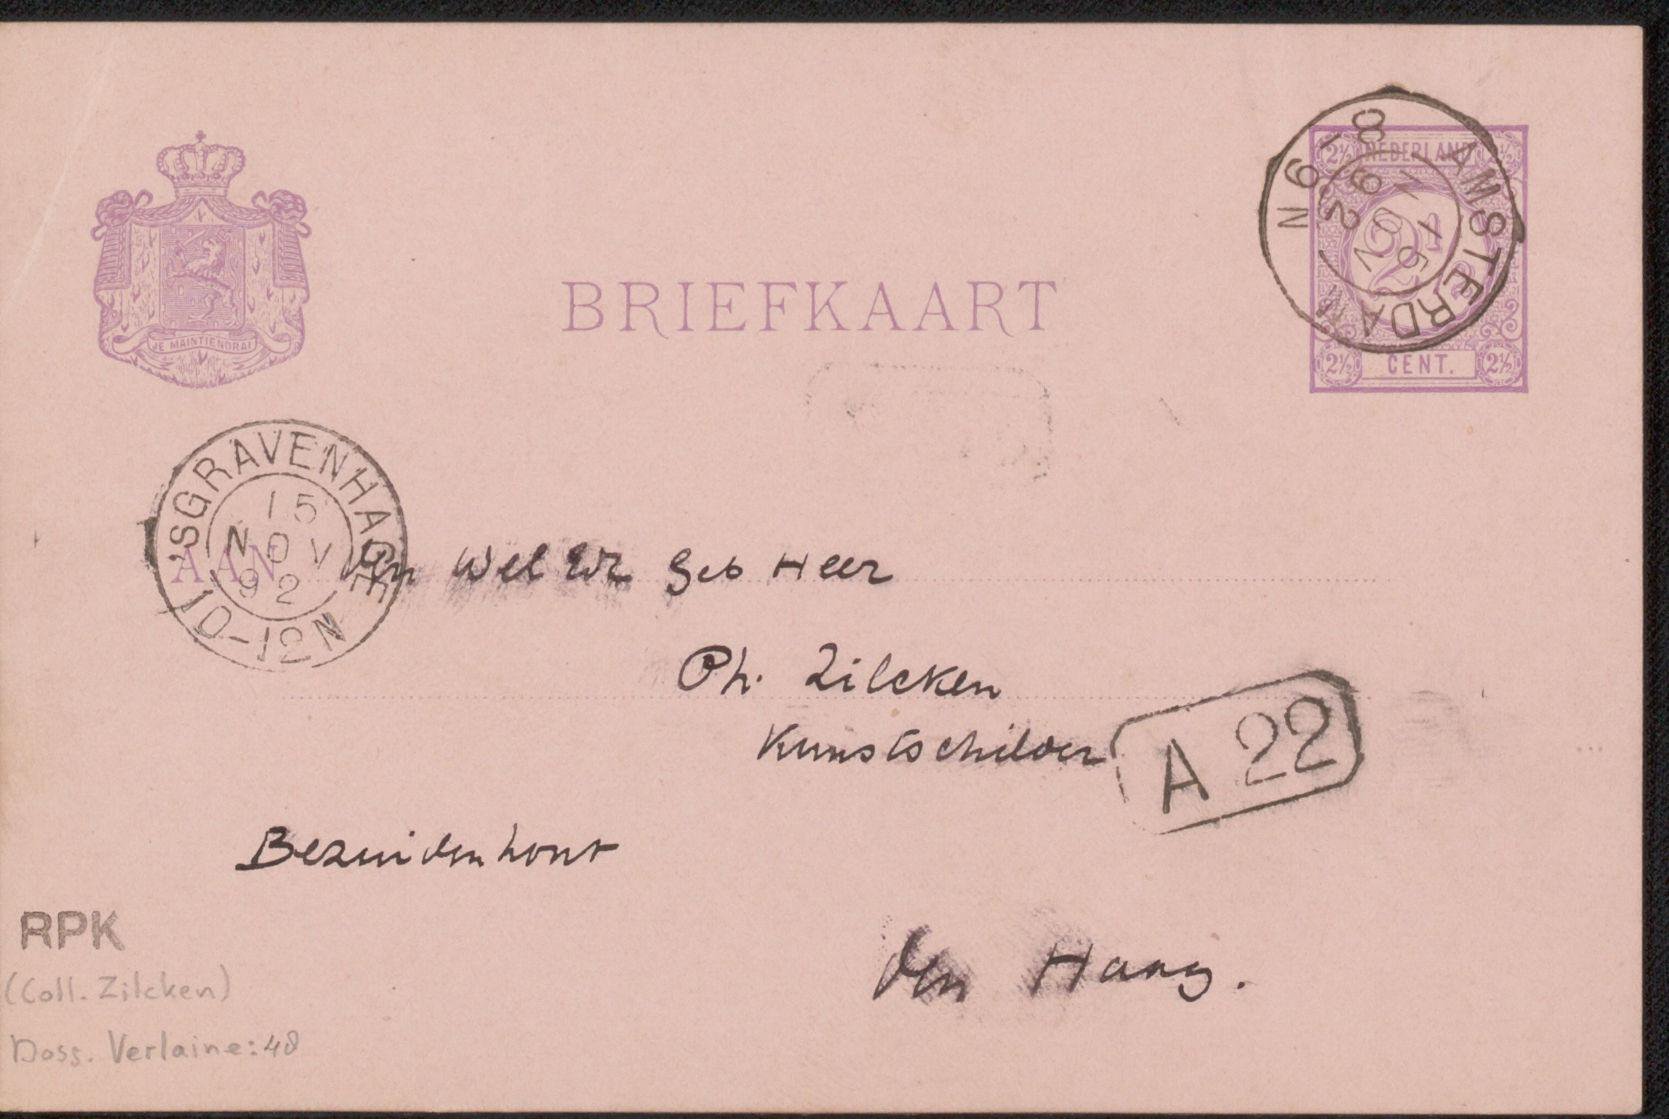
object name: postcard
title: Briefkaart aan Philip Zilcken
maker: richard nicolaüs roland holst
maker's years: 1868-1938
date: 1892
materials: cardboard, ink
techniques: pen, writing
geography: amsterdam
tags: amsterdam, painter, print maker, draughtsman, willem witsen, willem kloos, paris, paul verlaine, adriaan roland holst, philip zilcken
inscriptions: collector's mark: ‘RPK’